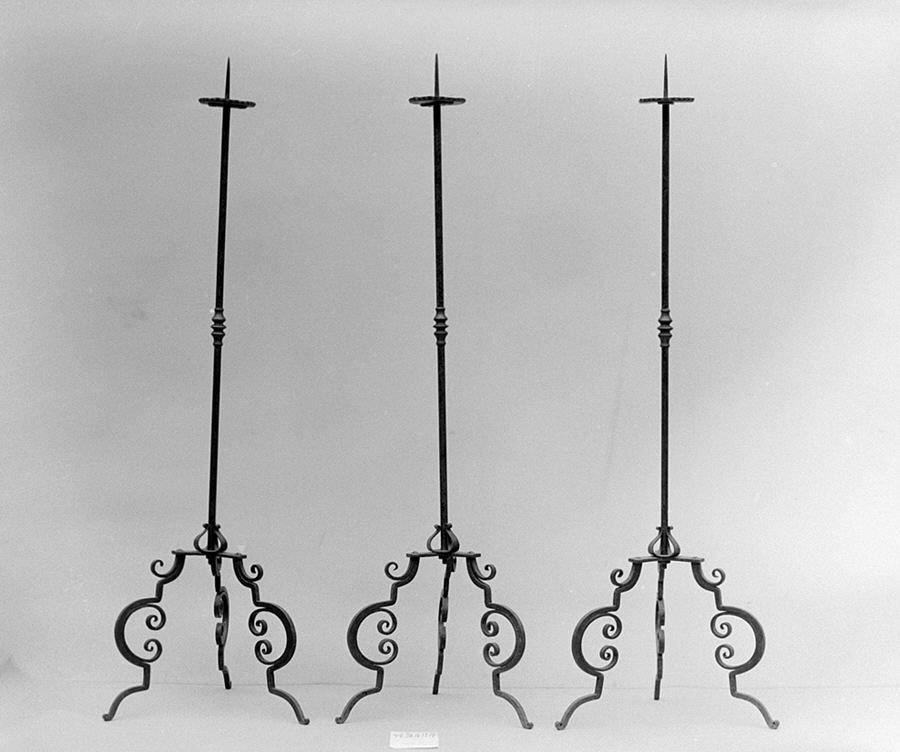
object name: torchères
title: Set of six torchères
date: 1601-1700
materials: brass, iron